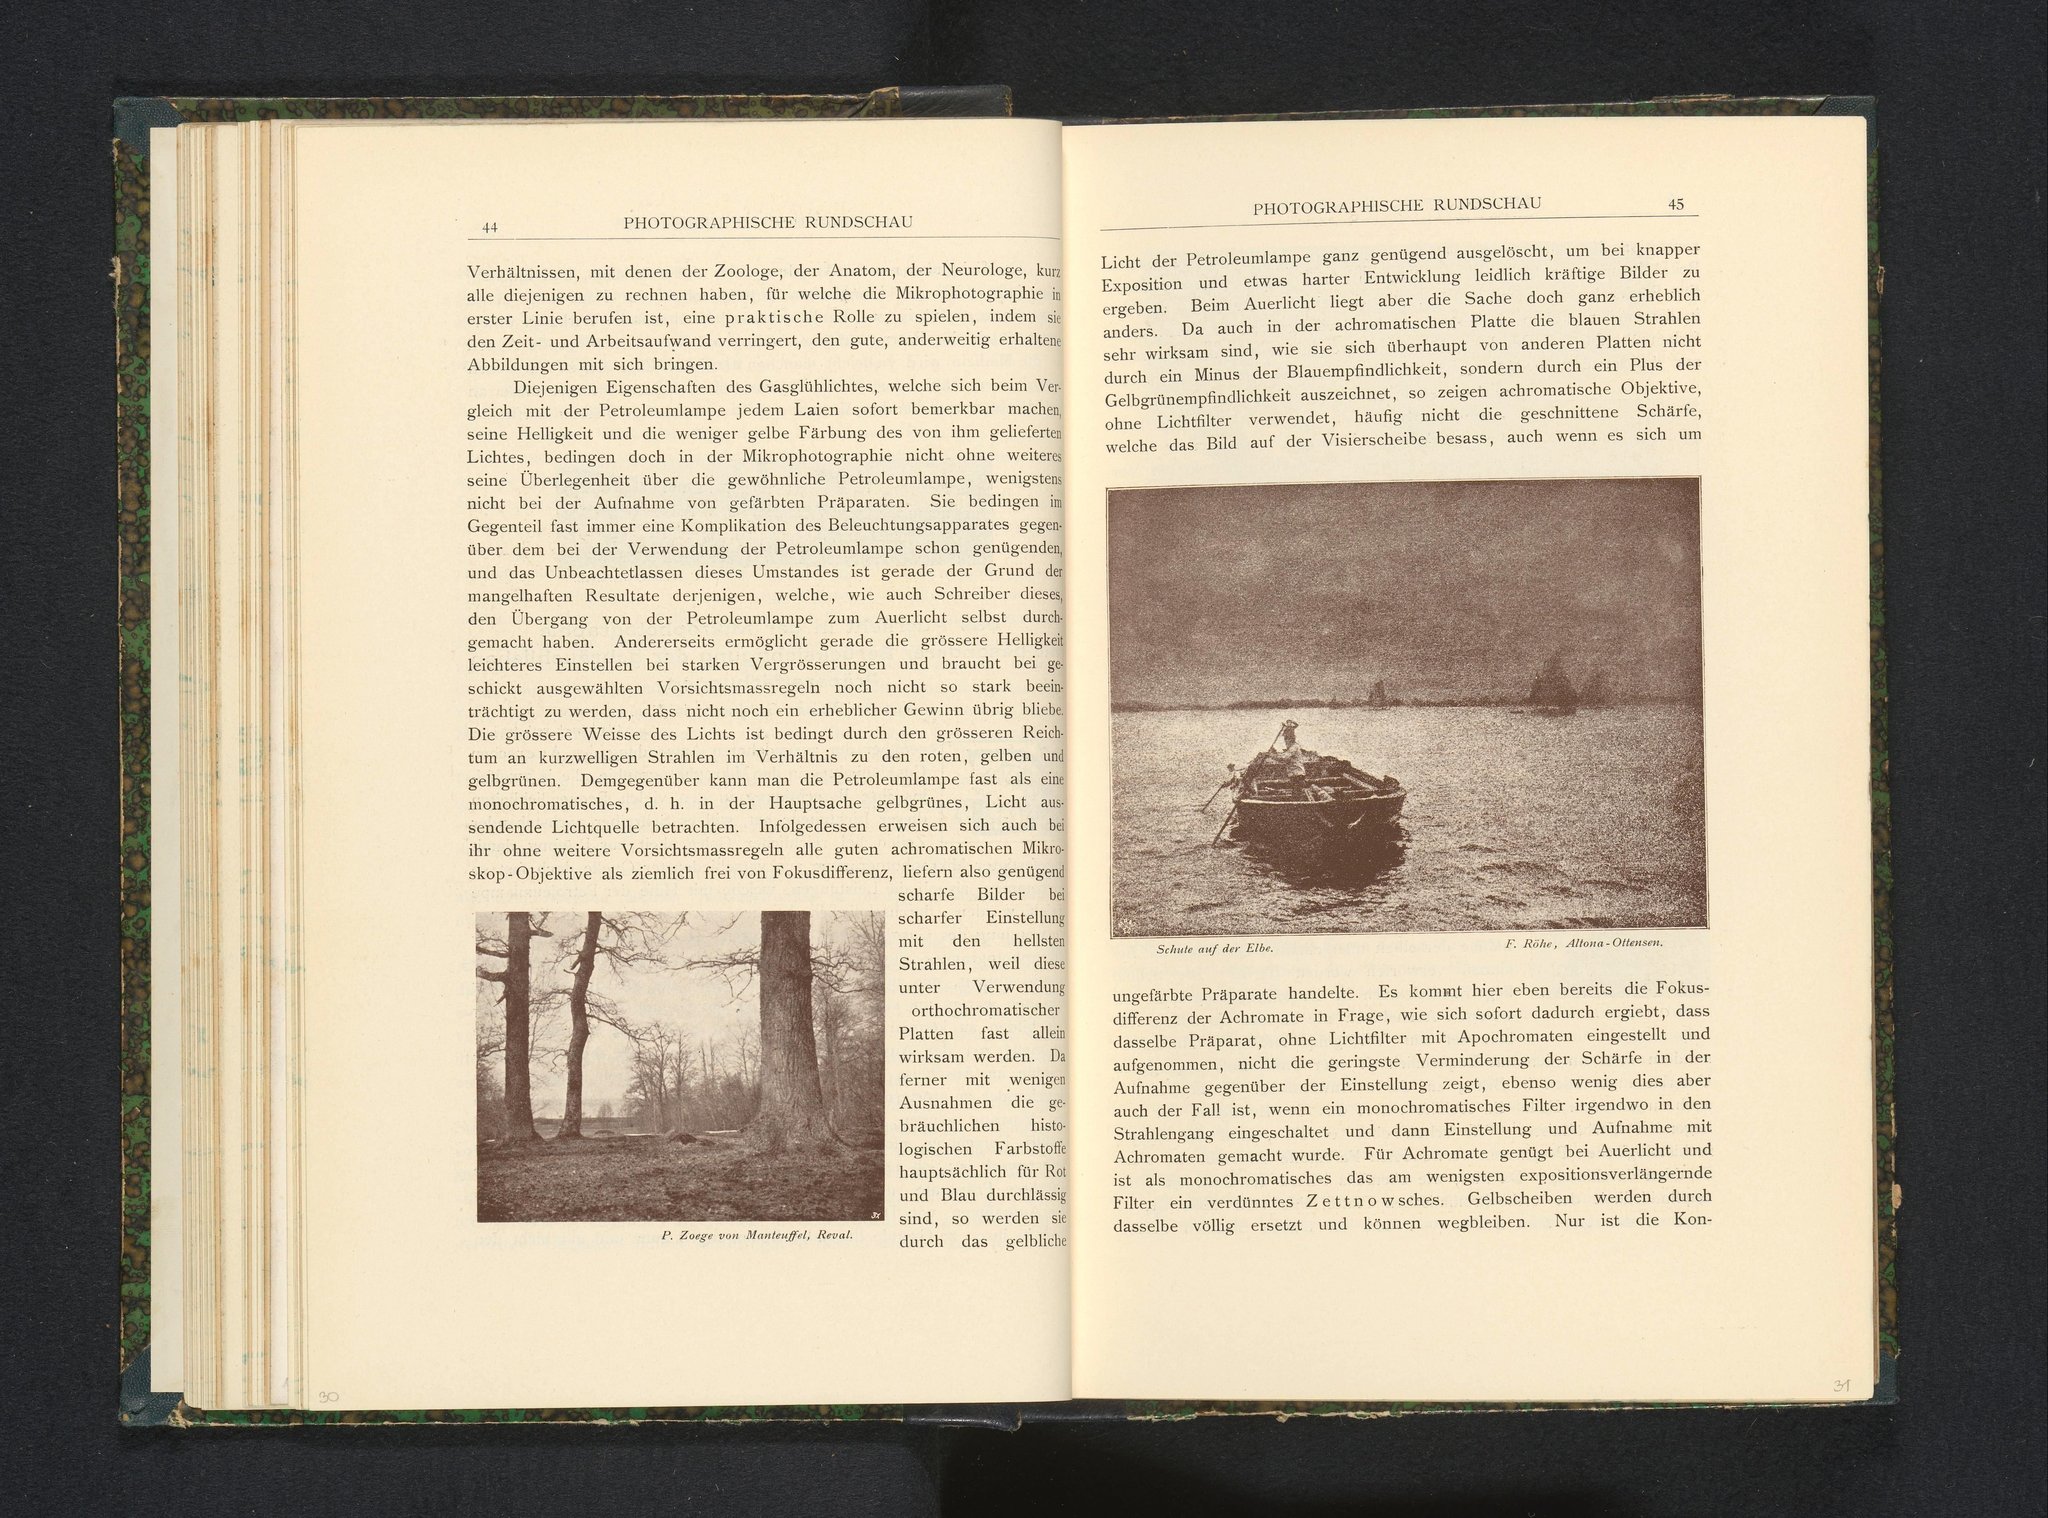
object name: page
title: Landschap met boomstammen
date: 1894-1899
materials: paper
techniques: autotype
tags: forest, wood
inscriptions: monogram: ‘BX’